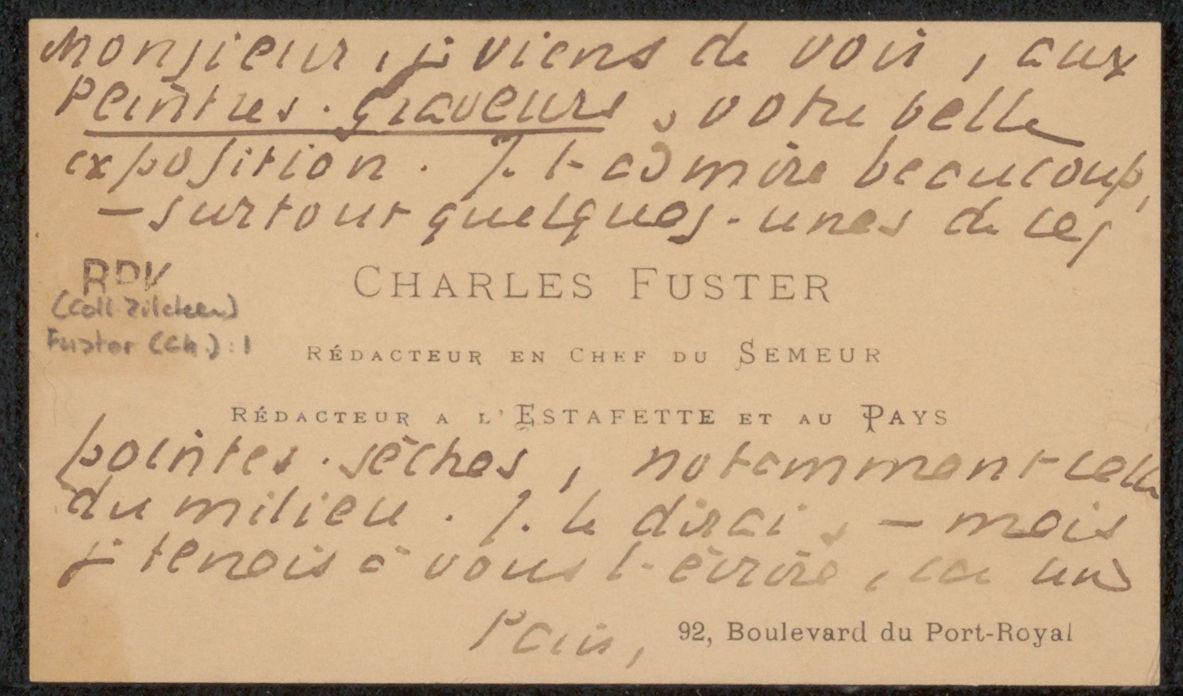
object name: visiting card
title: Visitekaartje aan Philip Zilcken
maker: charles fuster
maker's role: criticus, dichter, romanschrijver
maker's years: 1866-1929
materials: cardboard, ink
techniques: pen, printing, writing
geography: paris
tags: painter, draughtsman, philip zilcken, the graphic arts, exhibition ~ art, netherlands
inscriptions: collector's mark: ‘RPK’